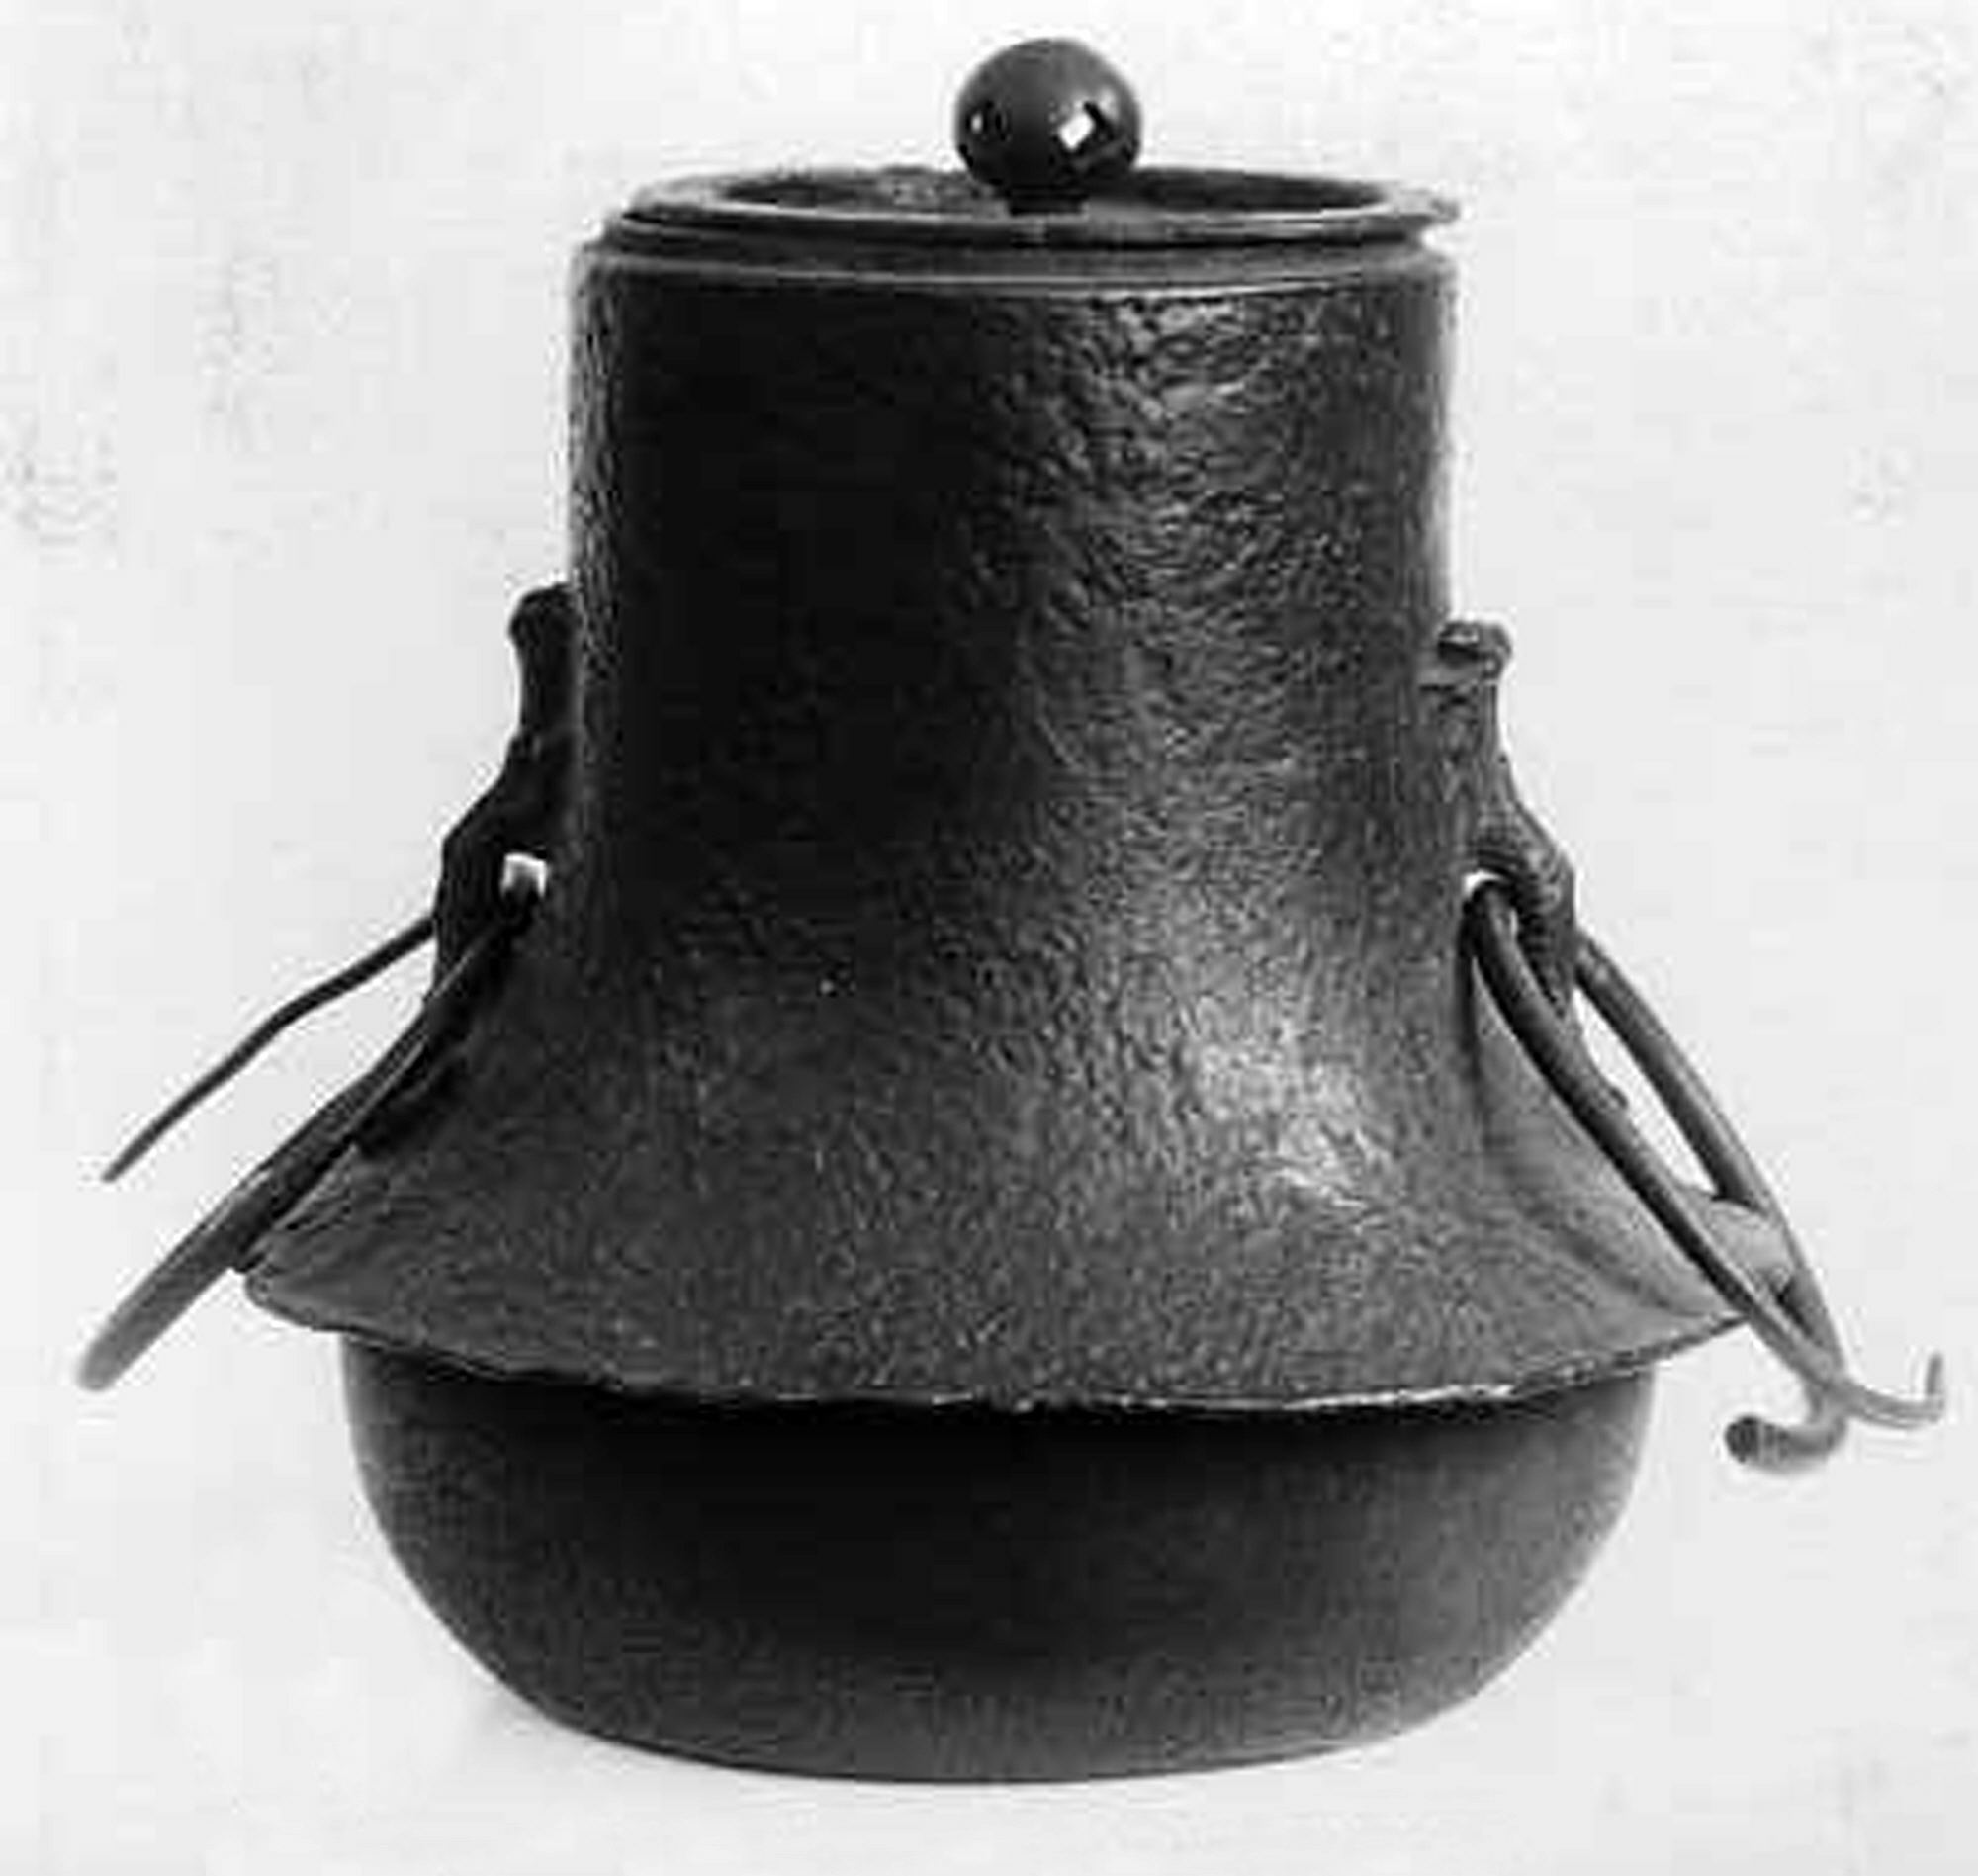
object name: water jar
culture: japanese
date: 1701-1800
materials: iron